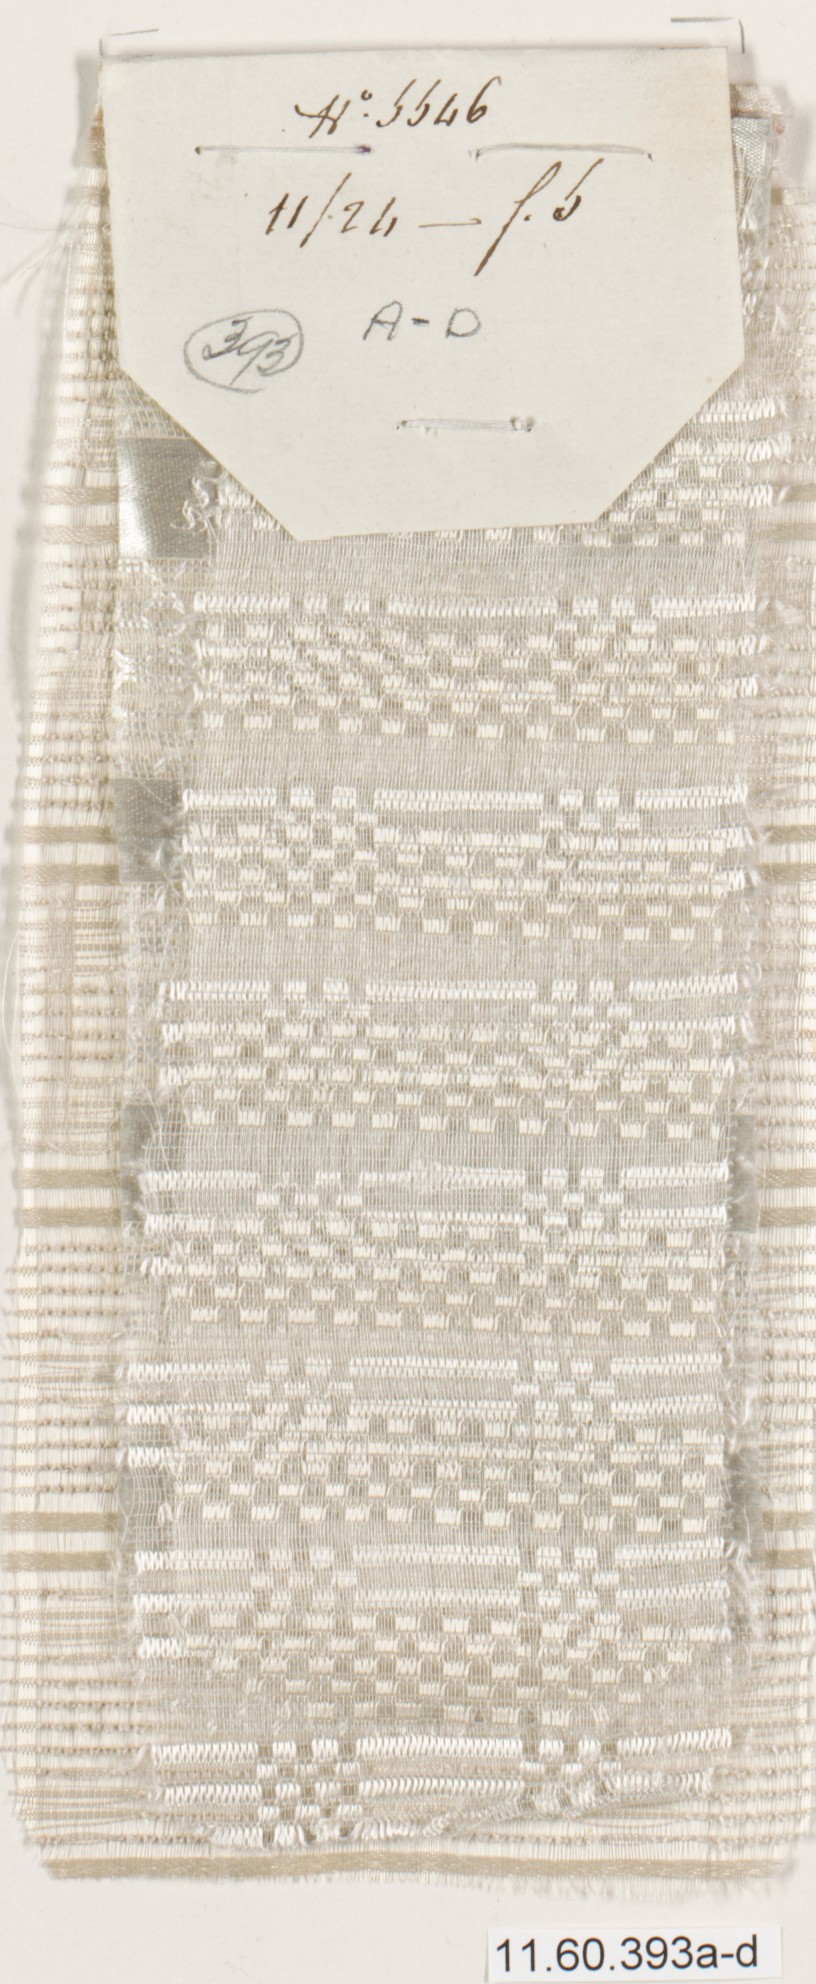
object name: fragment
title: Fragments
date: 1801-1900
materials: silk